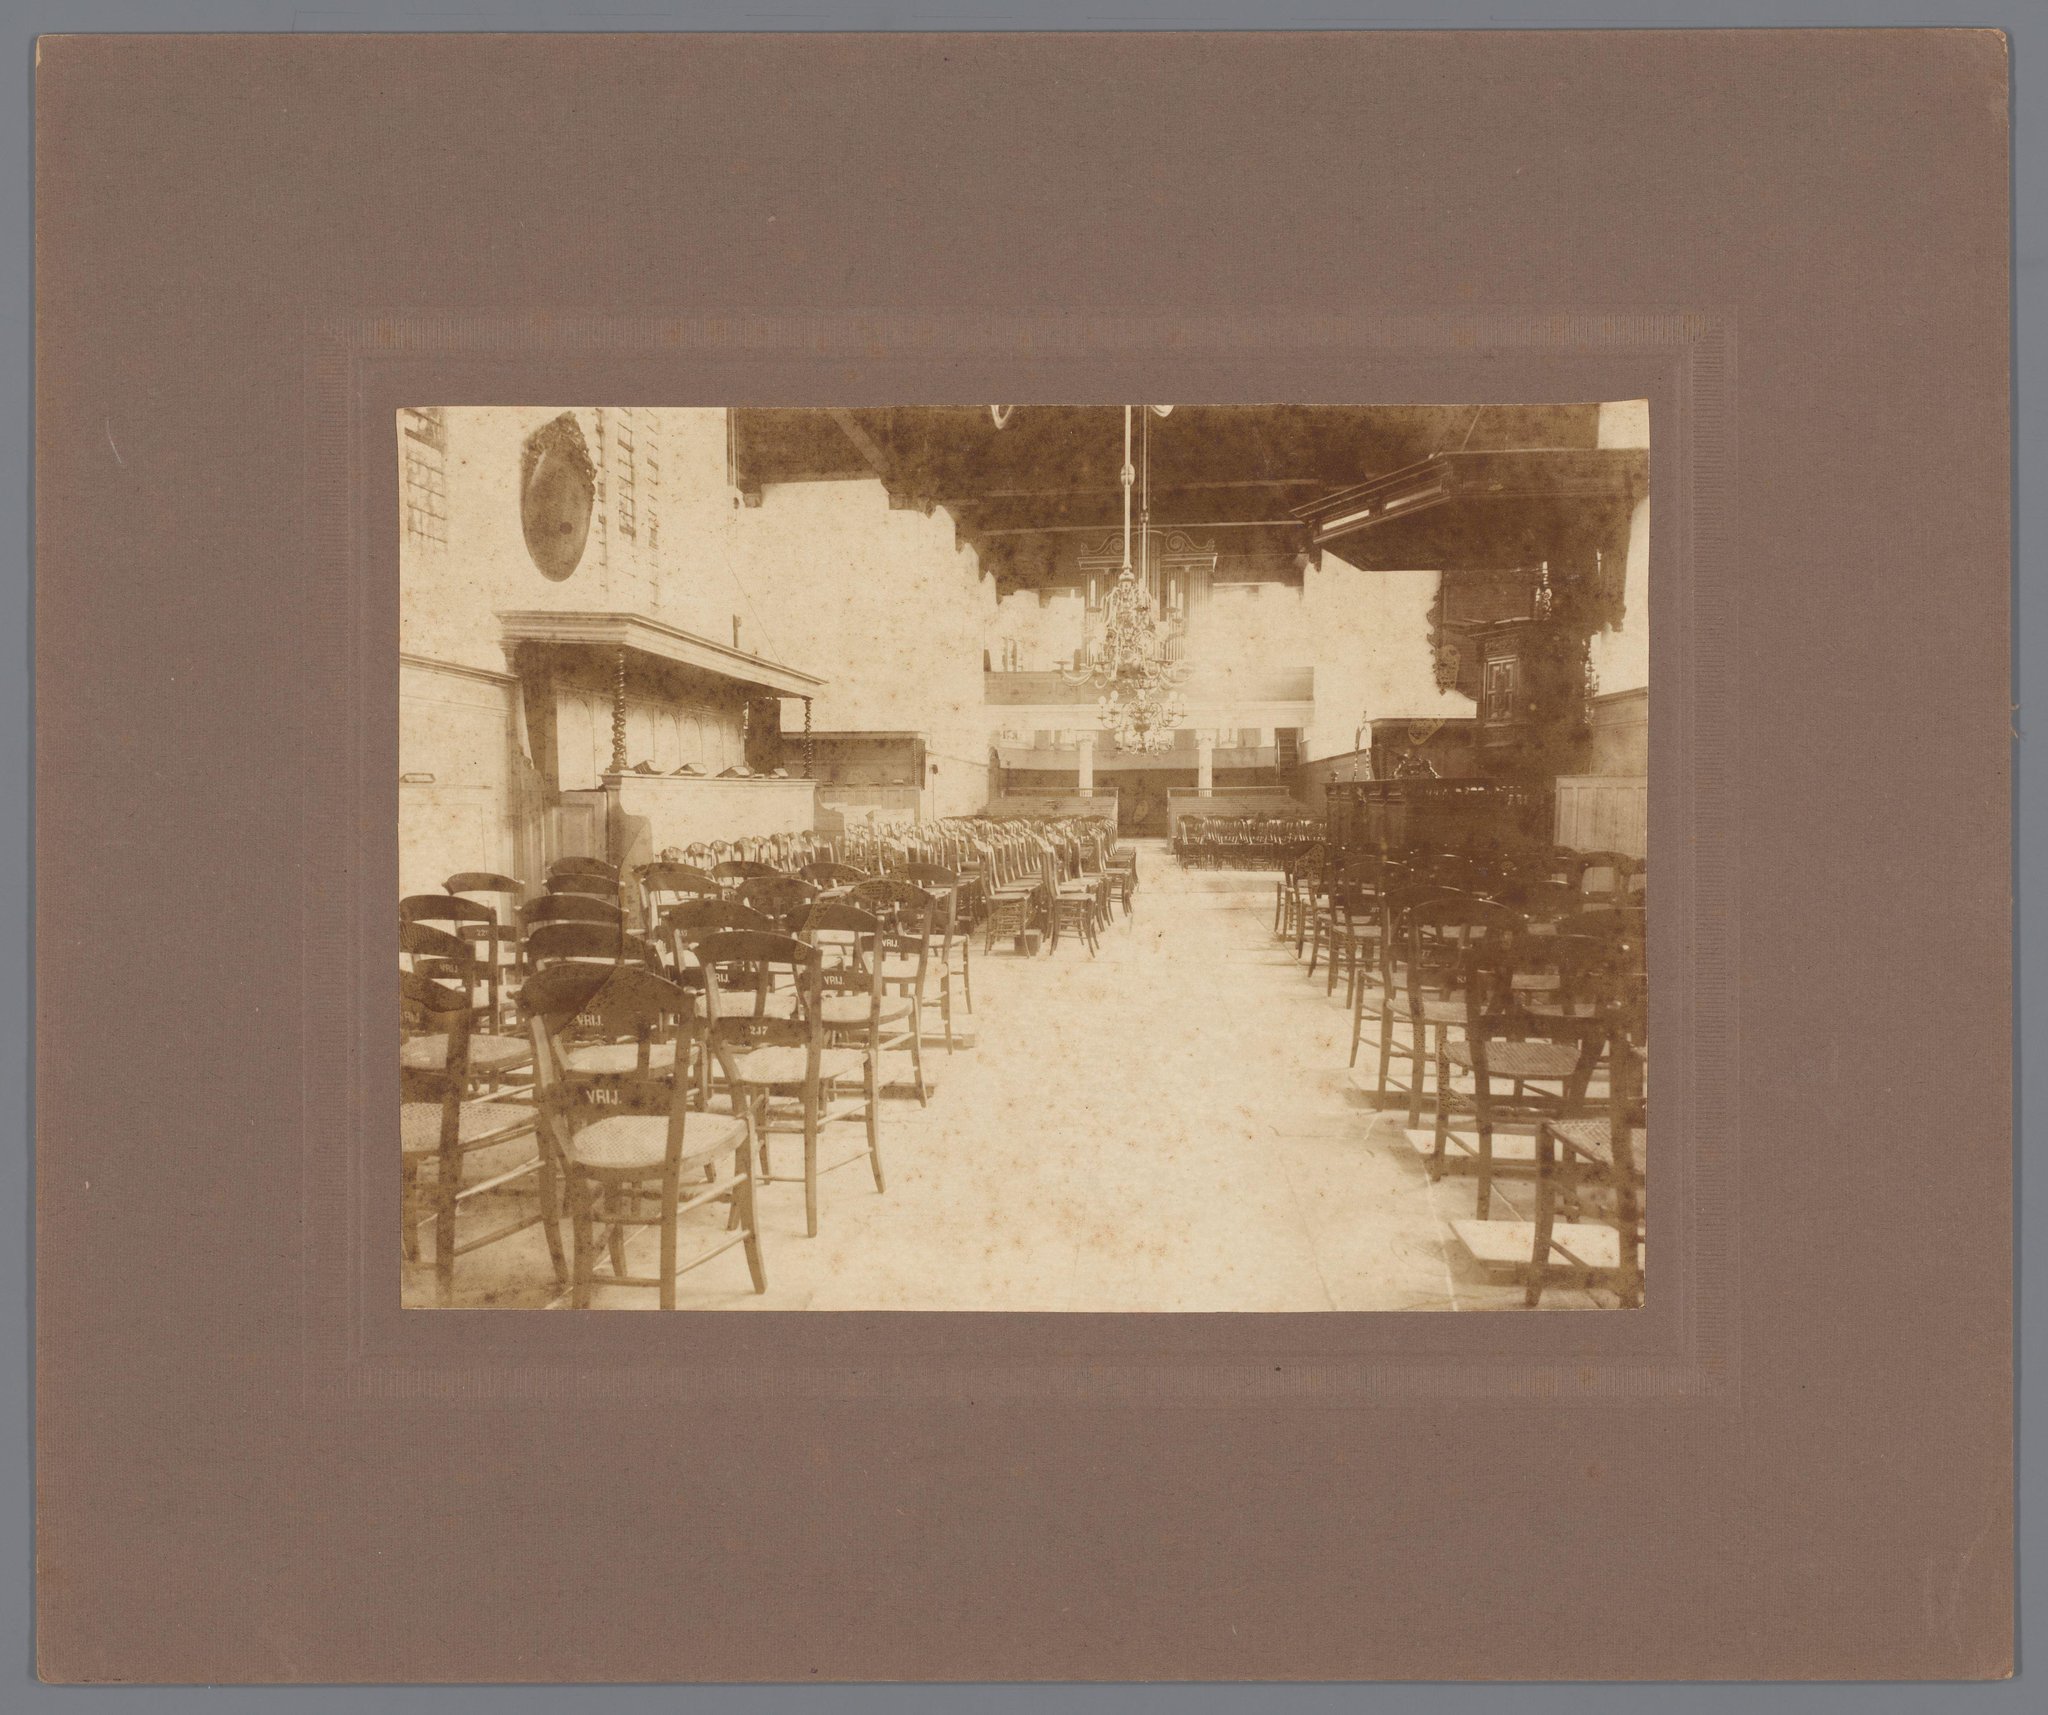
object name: photograph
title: Interieur van de Nederlands Hervormde Kerk in De Rijp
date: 1921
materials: cardboard, photographic support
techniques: gelatin silver print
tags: de rijp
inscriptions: annotation: ‘De Rijp 1921’, date